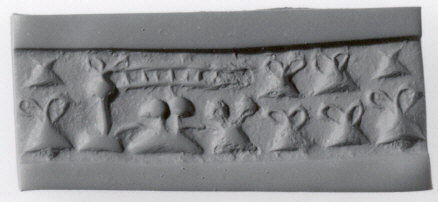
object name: cylinder seal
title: Cylinder seal and modern impression: "pigtailed" ladies in front of loom (?); containers with loop handle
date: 3300-2900 BCE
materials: mineral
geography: iran or mesopotamia